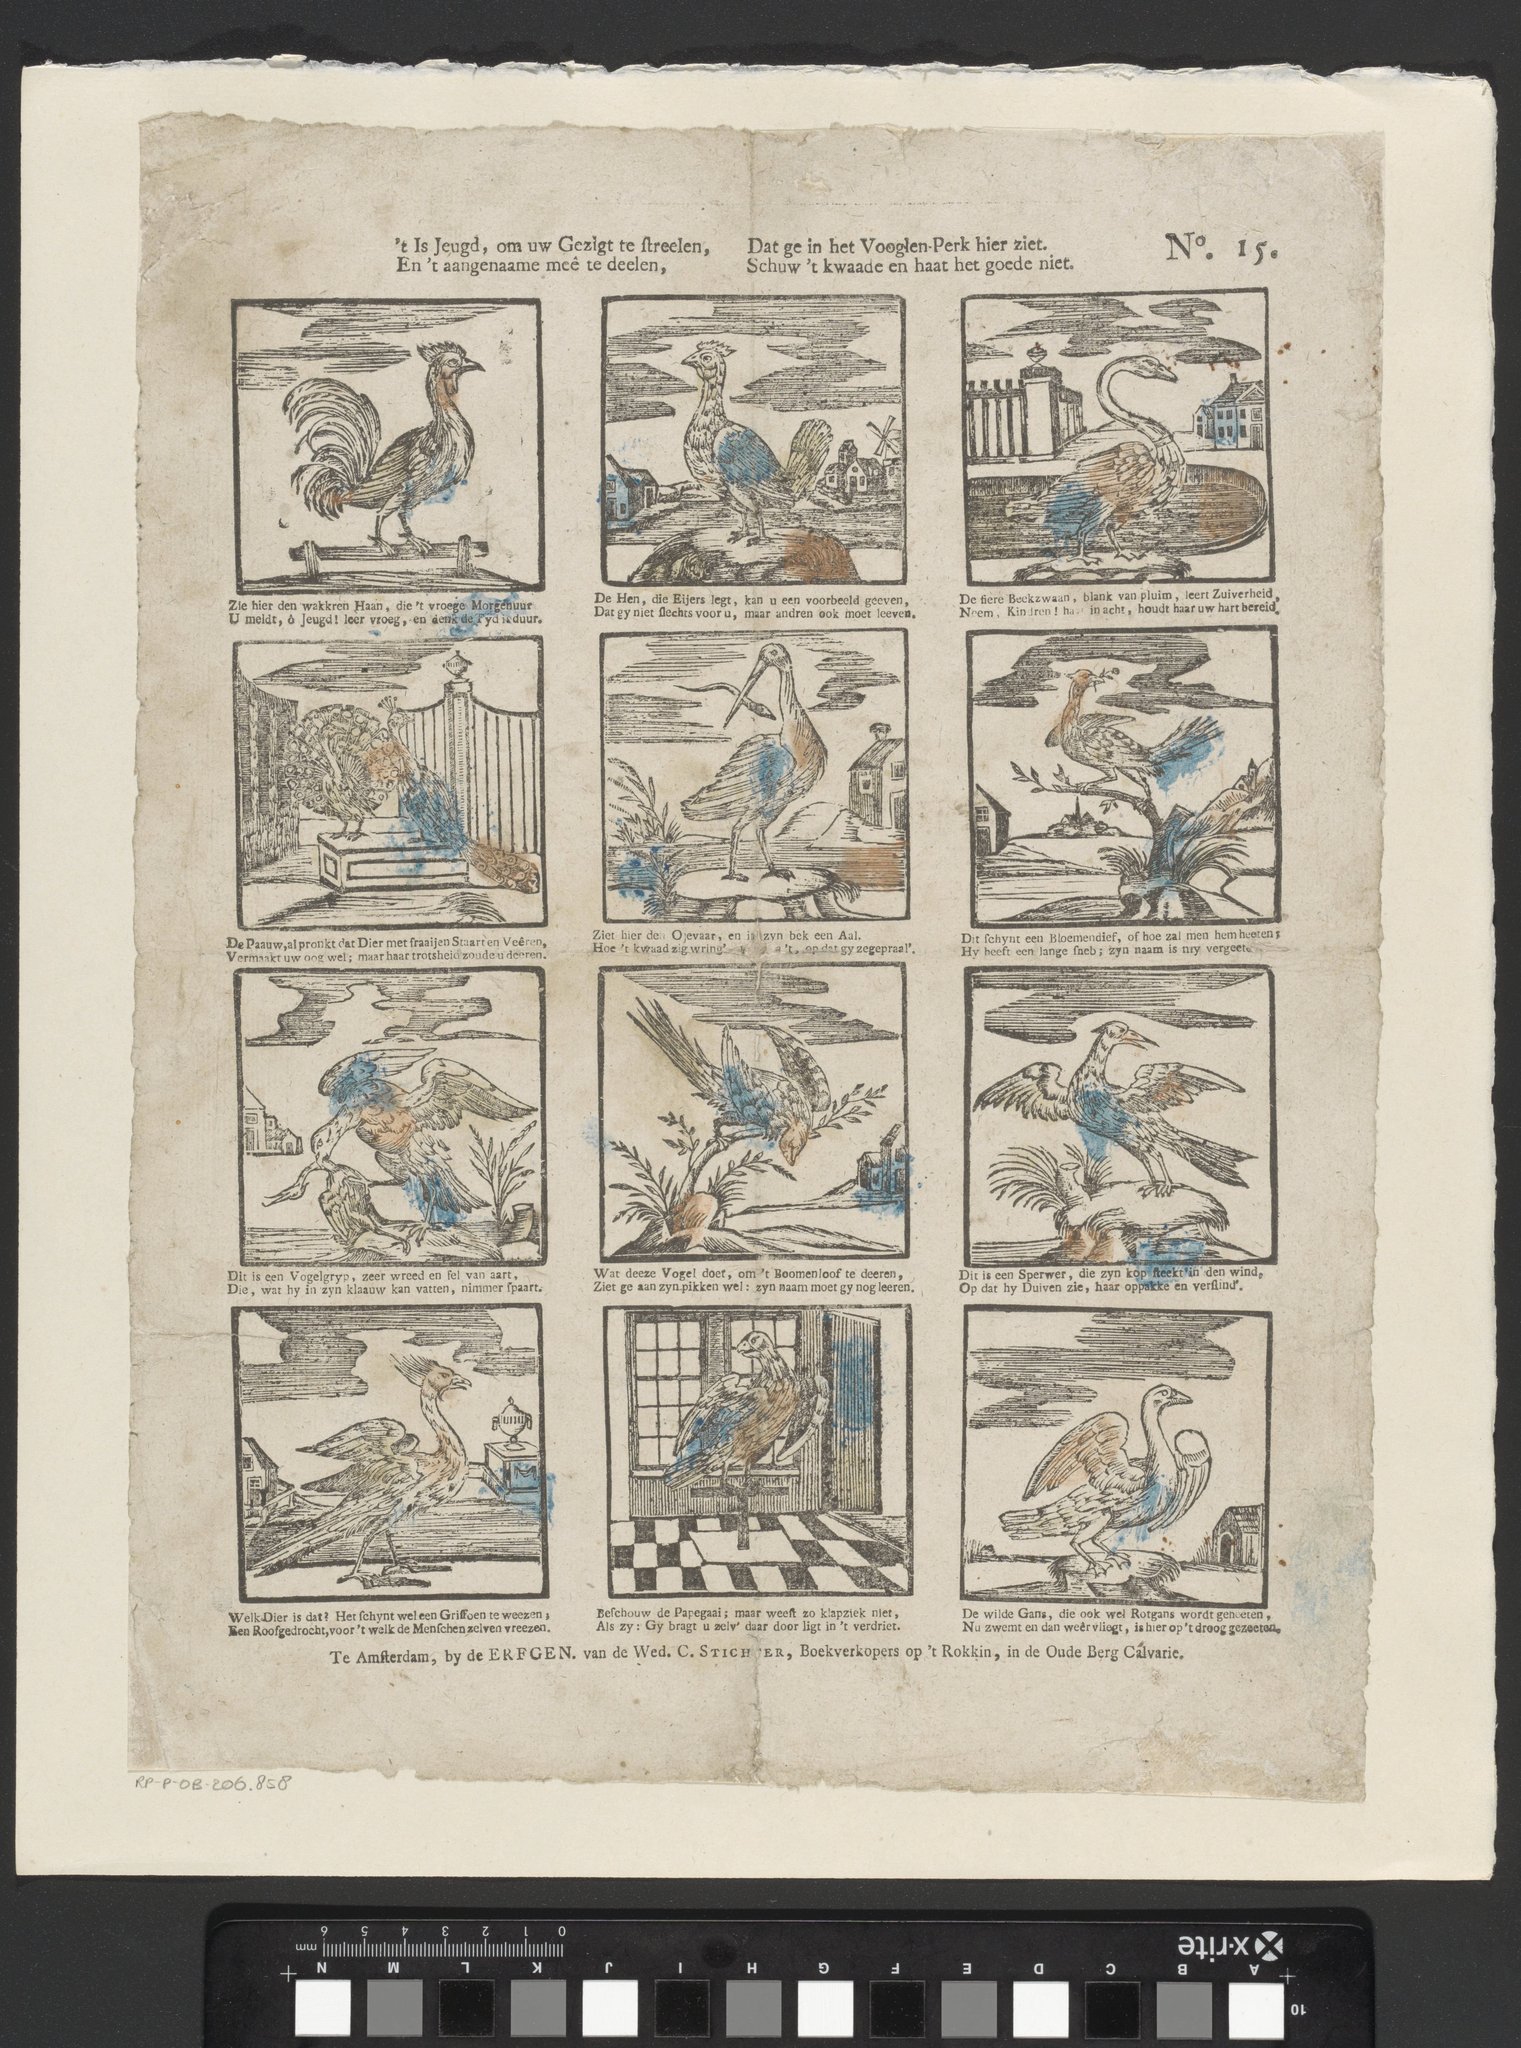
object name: print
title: 'T is jeugd, om uw gezigt te streelen, / En 't aangenaame meê te deelen, / Dat ge in het vooglen-perk hier ziet. / Schuw 't kwaade en haat het goede niet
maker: Anonymous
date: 1715-1813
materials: paper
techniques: colour, letterpress printing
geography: amsterdam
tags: birds, fowl (cock, hen, chicken, etc.)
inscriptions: collector's mark: Lugt 2760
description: Blad met 12 voorstellingen van vogels, zoals een haan, een ooievaar en een papegaai. Onder elke afbeelding een tweeregelig vers. Genummerd rechtsboven: No. 15.